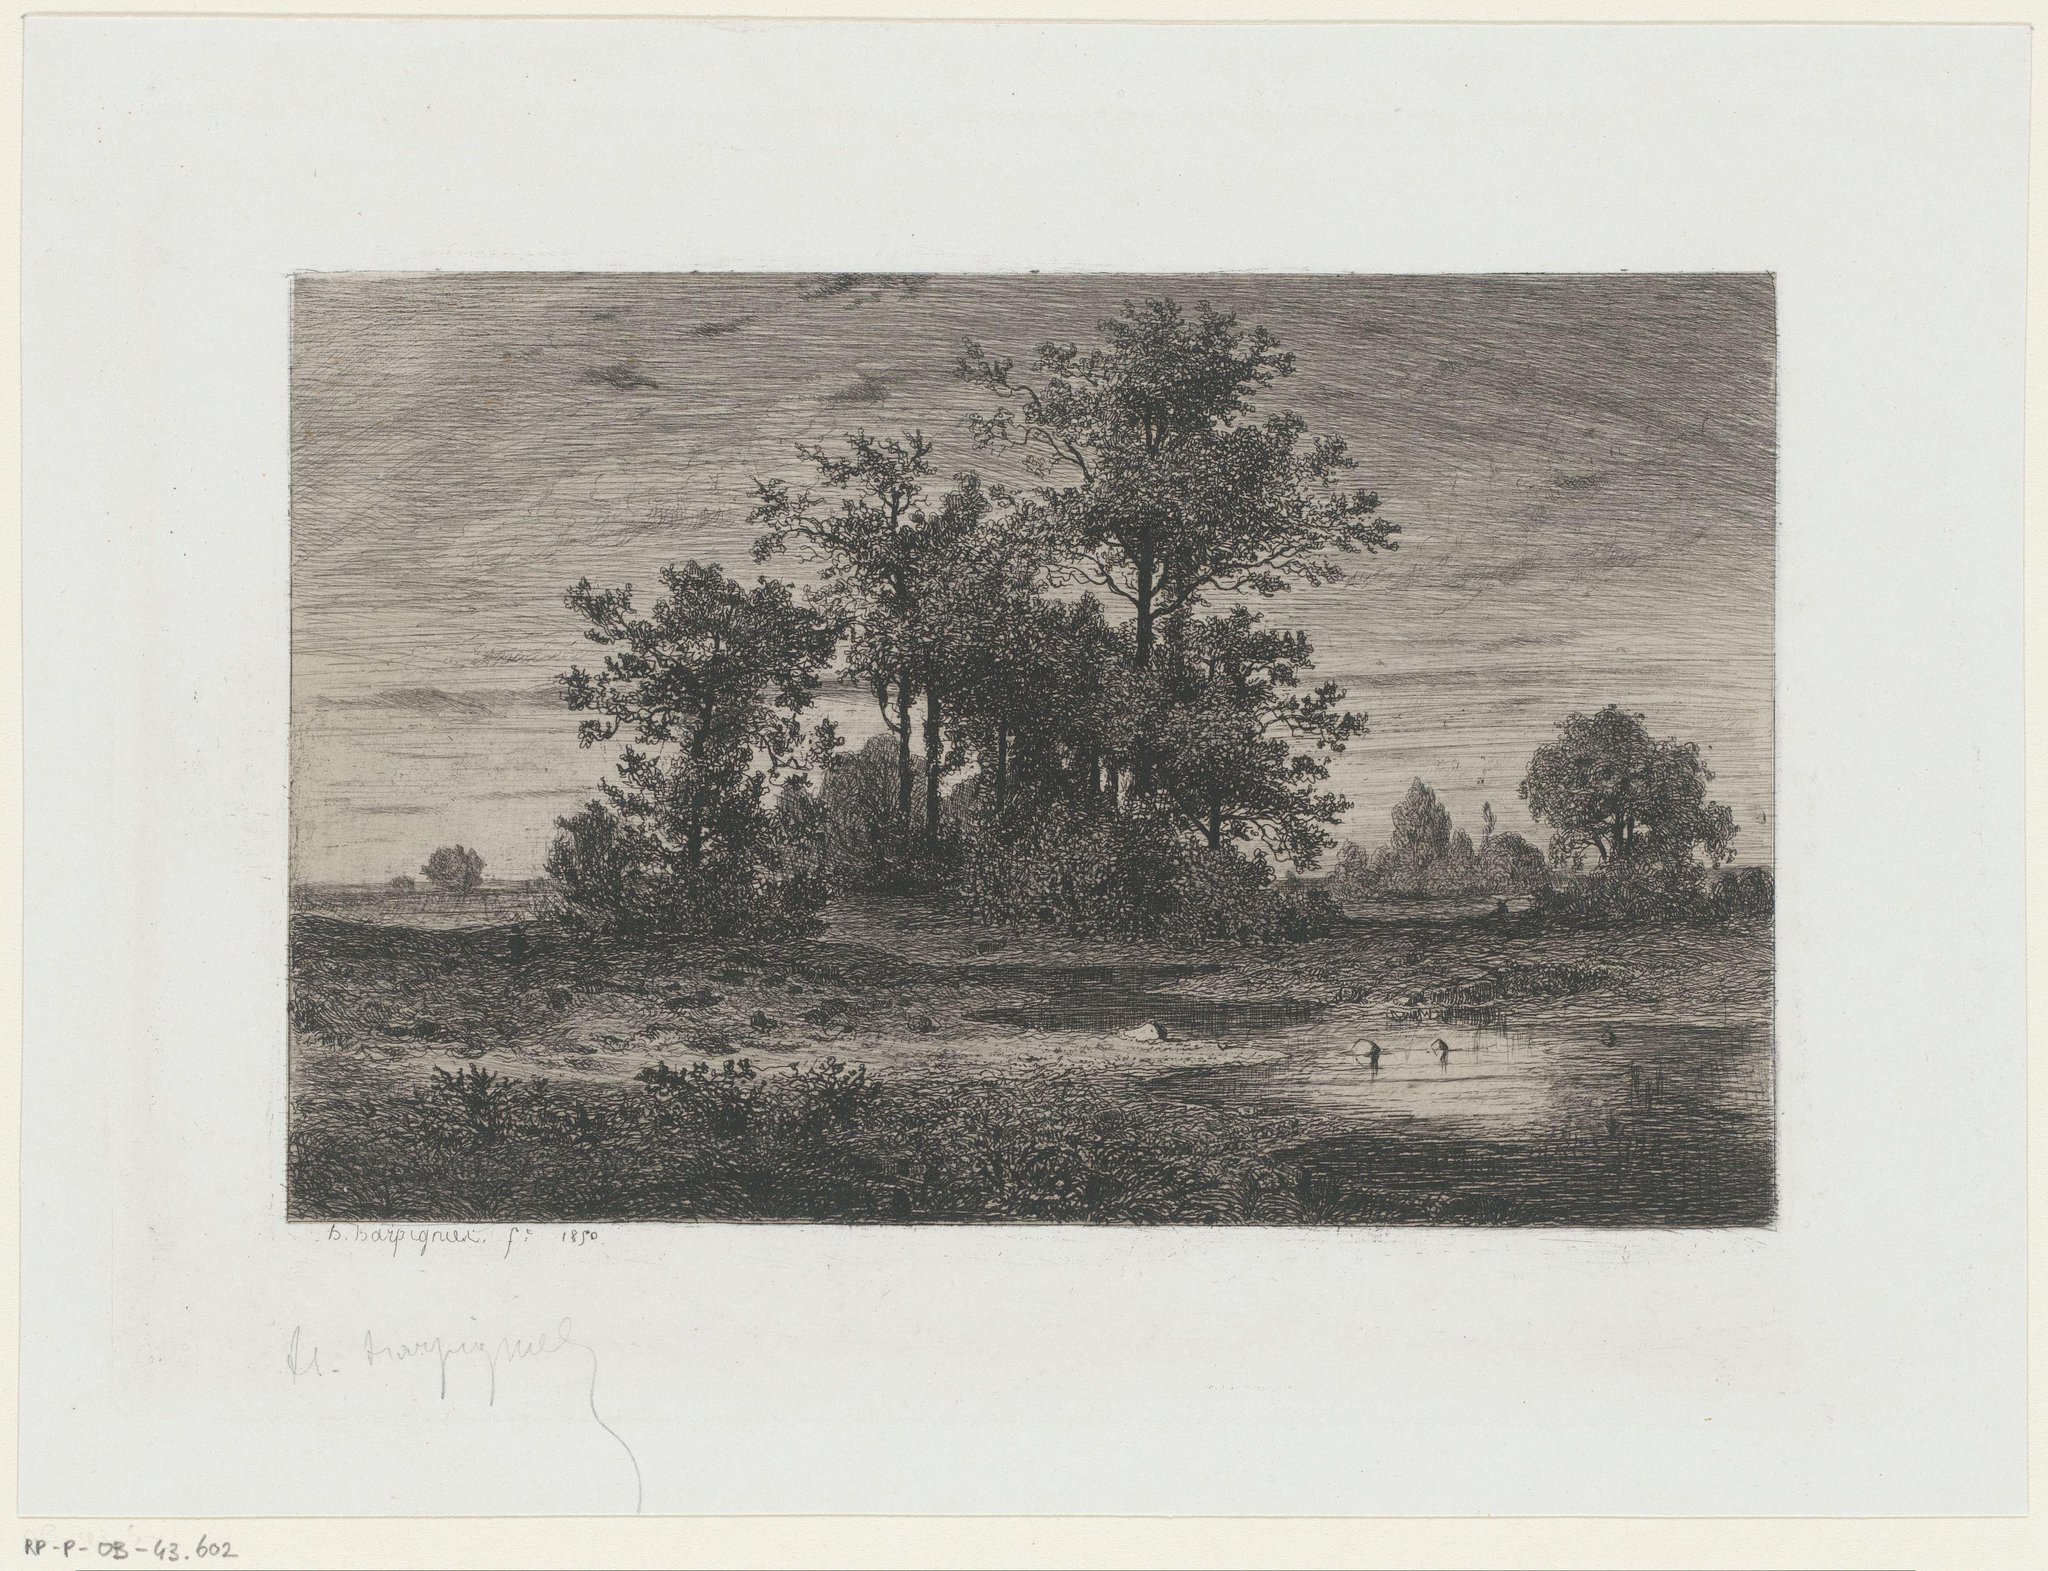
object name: print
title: Landschap met een plas voor een boompartij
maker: henri joseph harpignies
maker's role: draughtsman, print maker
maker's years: 1819-1916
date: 1850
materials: paper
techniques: etching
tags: landscapes, pond, pool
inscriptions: date